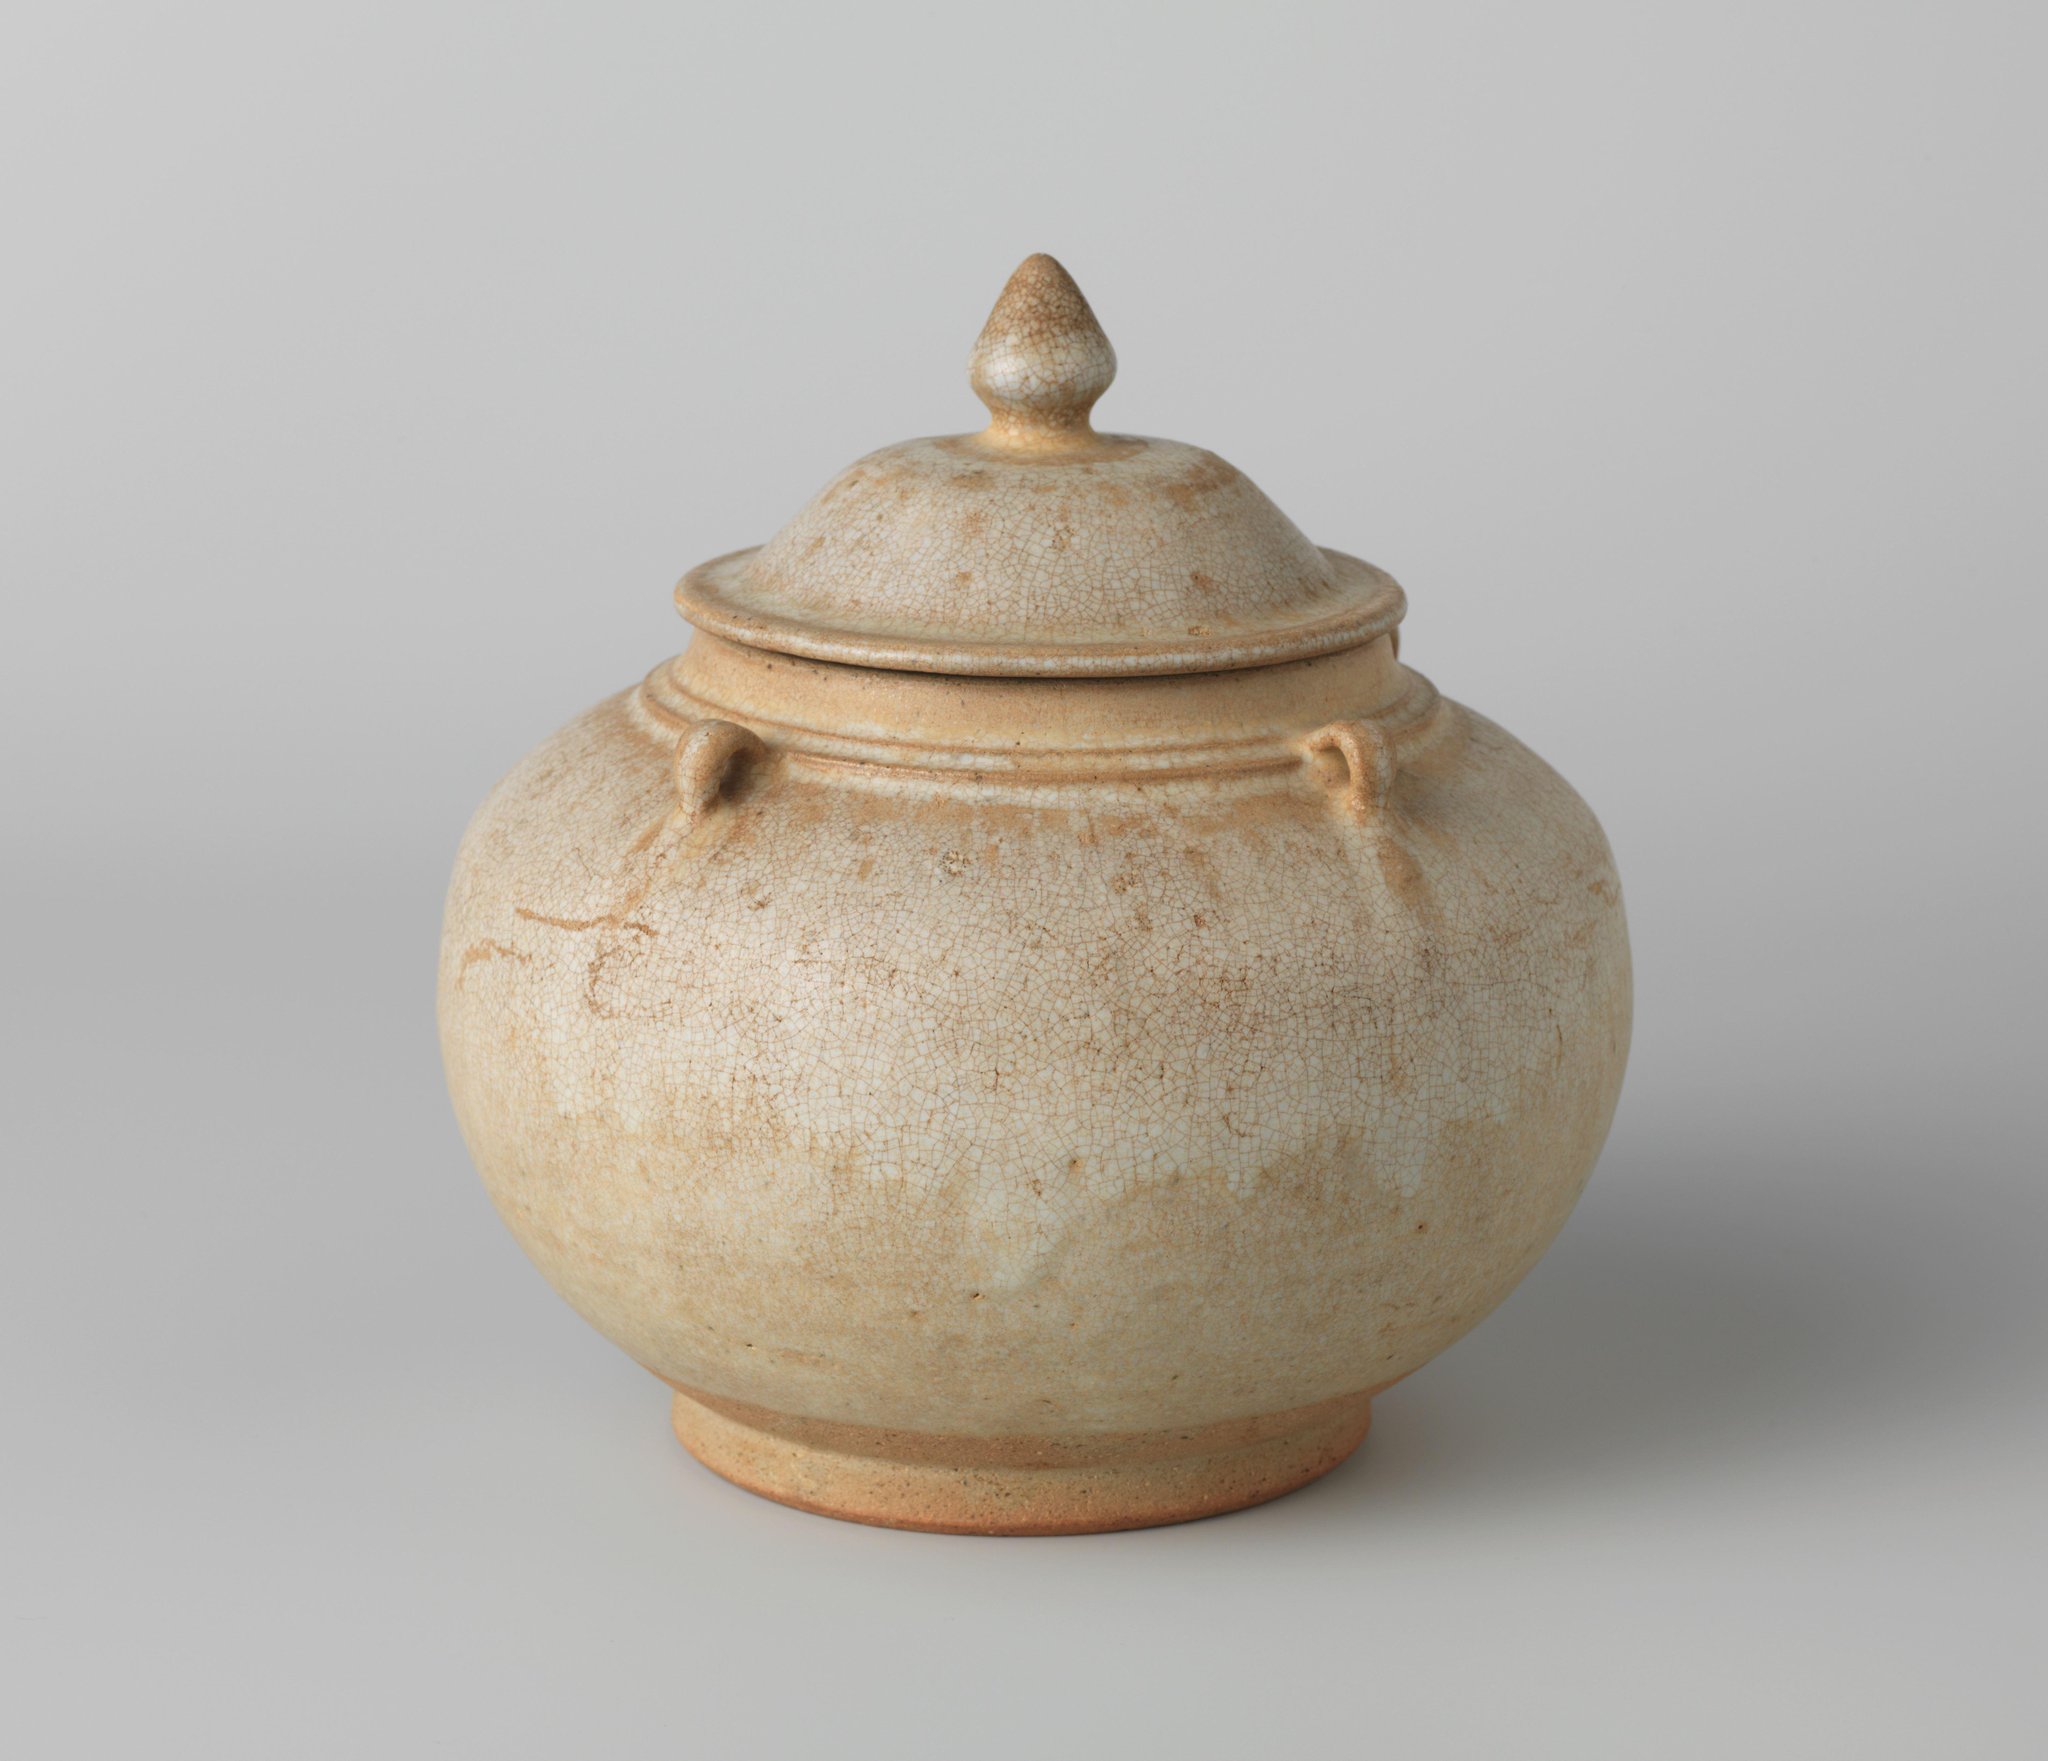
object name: lid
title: Ovoid covered jar with a light blue glaze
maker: Anonymous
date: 1400-1599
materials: glaze, stoneware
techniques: firing, turning, vitrification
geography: sawankhalok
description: Pot op een voetring; een klokvormige deksel met dekselknop. De pot is bedekt met een witte tot crèmekleurige glazuur met een fijne craquelure.